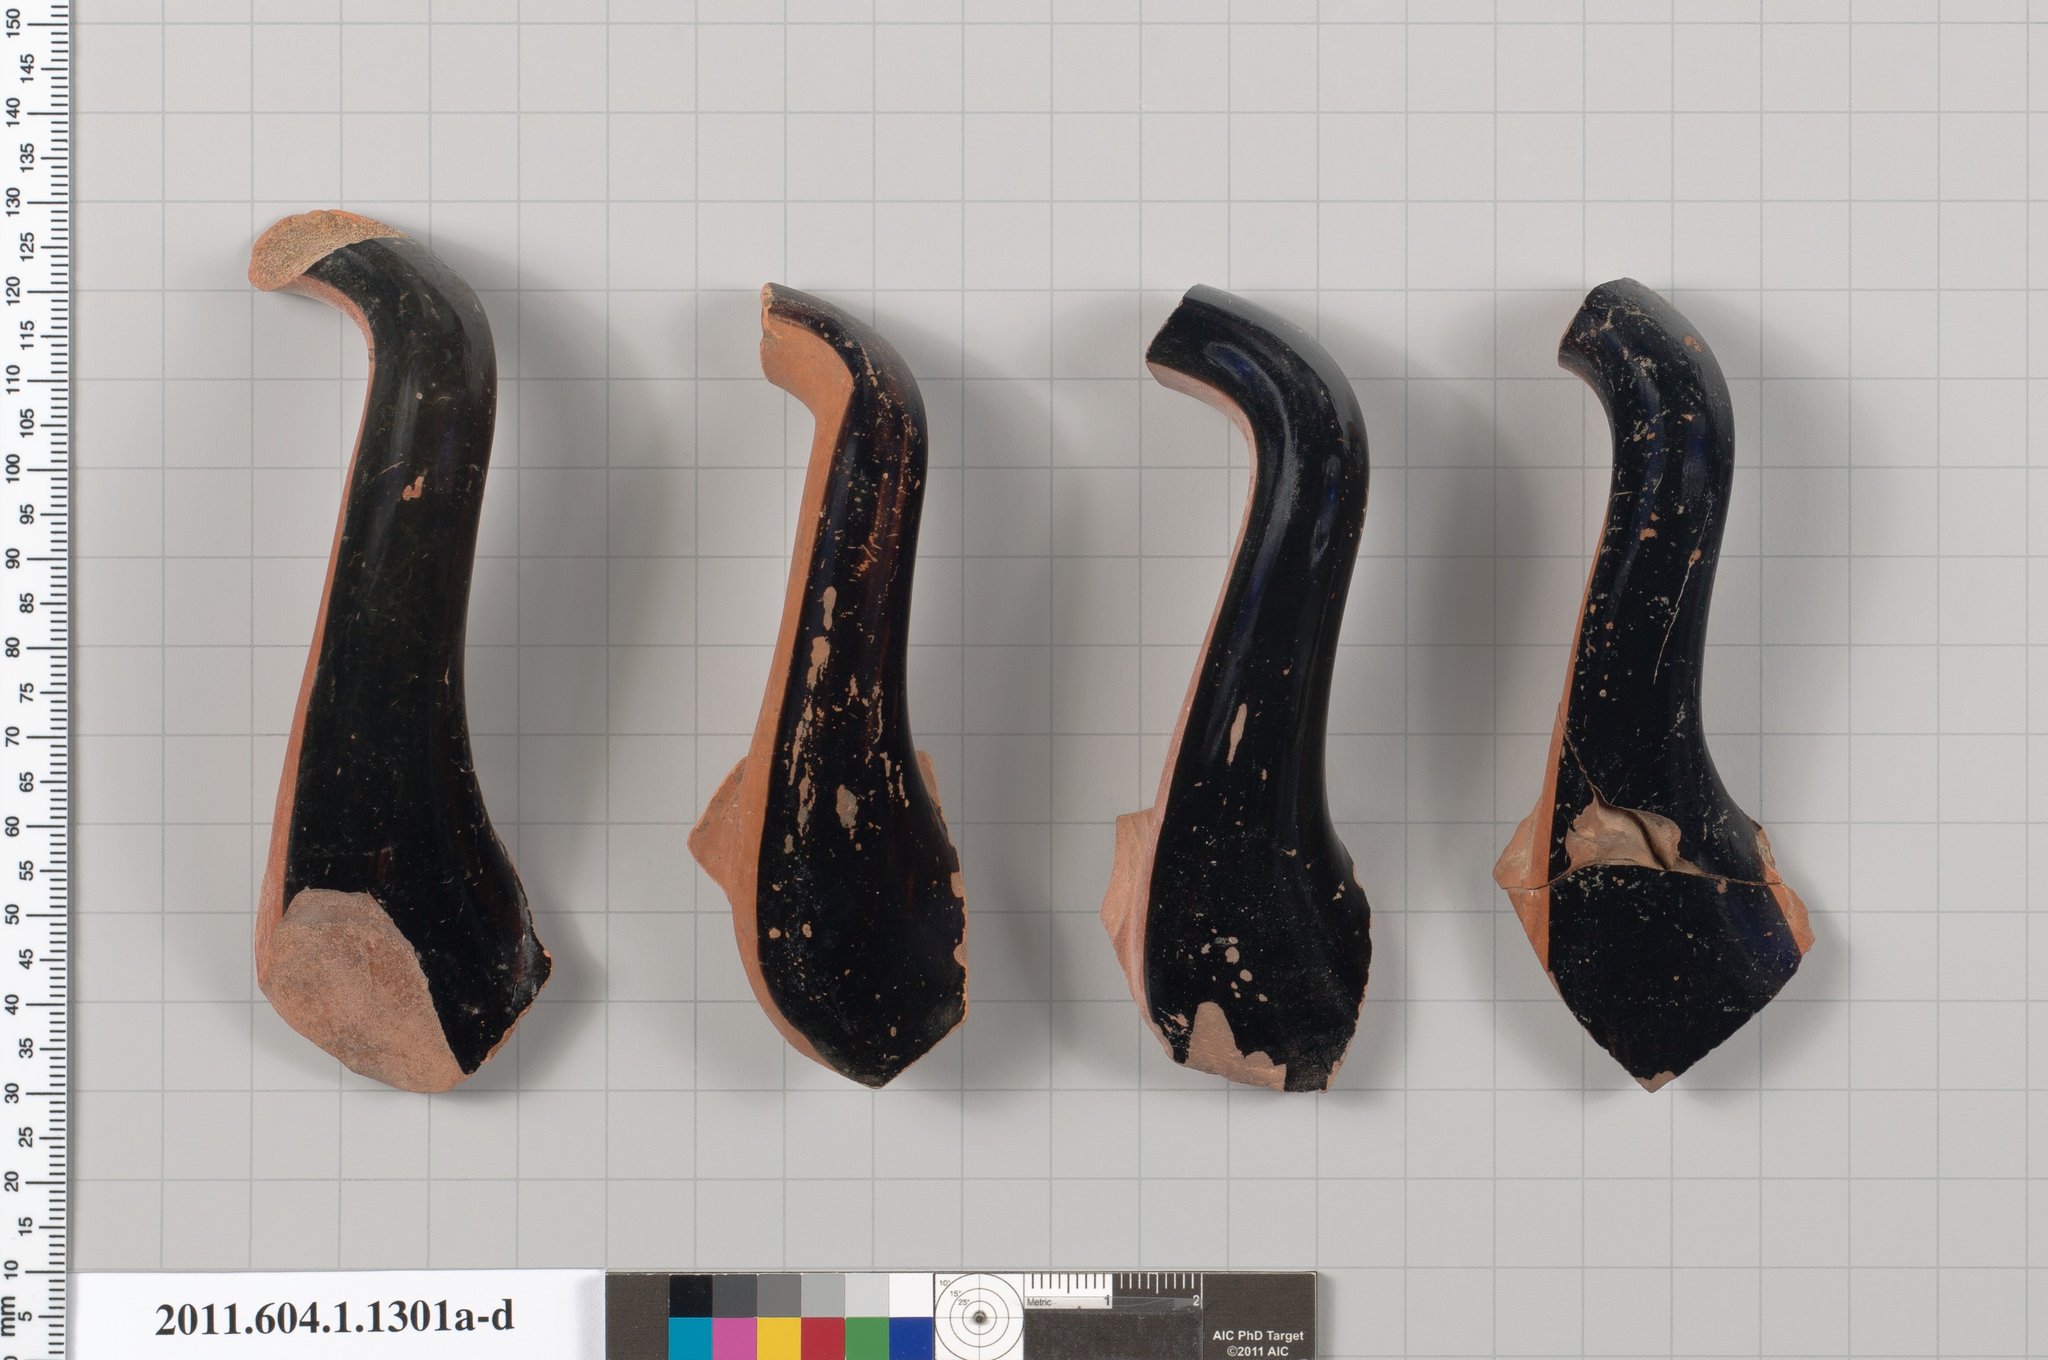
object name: kylix fragment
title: Terracotta fragments of kylikes (drinking cups)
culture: greek, attic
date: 500-401 BCE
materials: terracotta